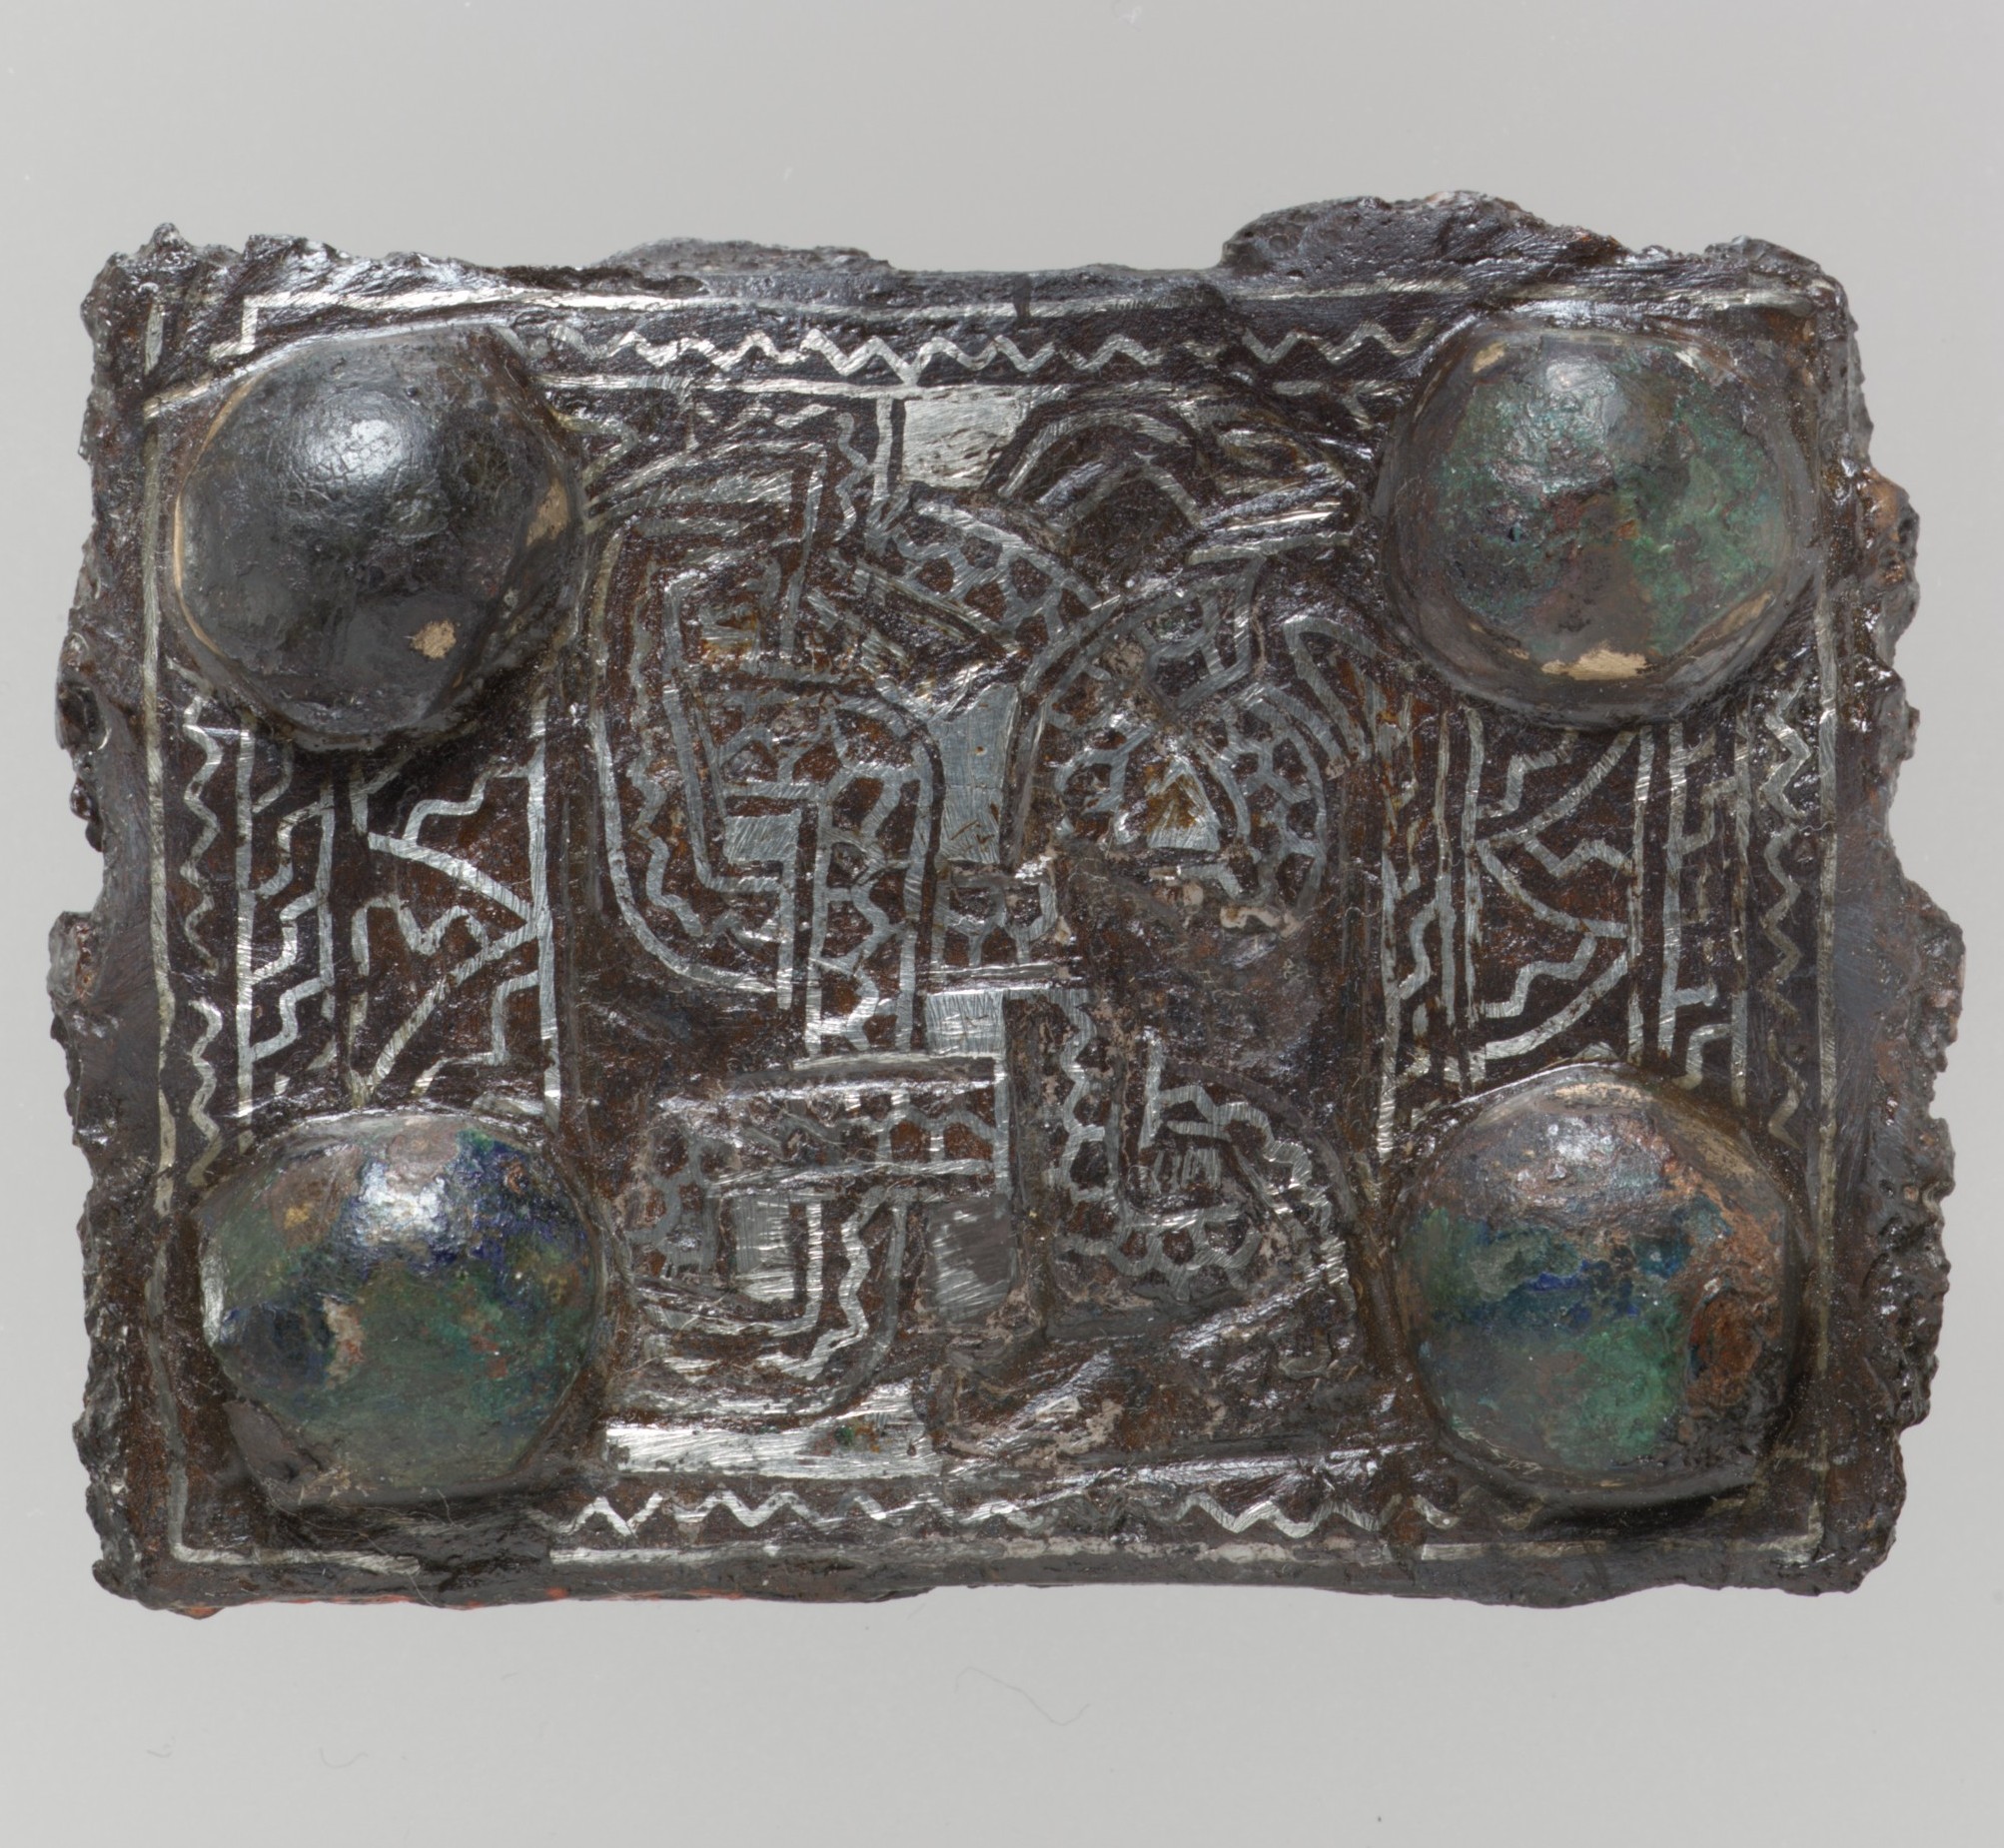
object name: belt plate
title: Back Plate from a Belt Buckle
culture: frankish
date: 675-725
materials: copper alloy